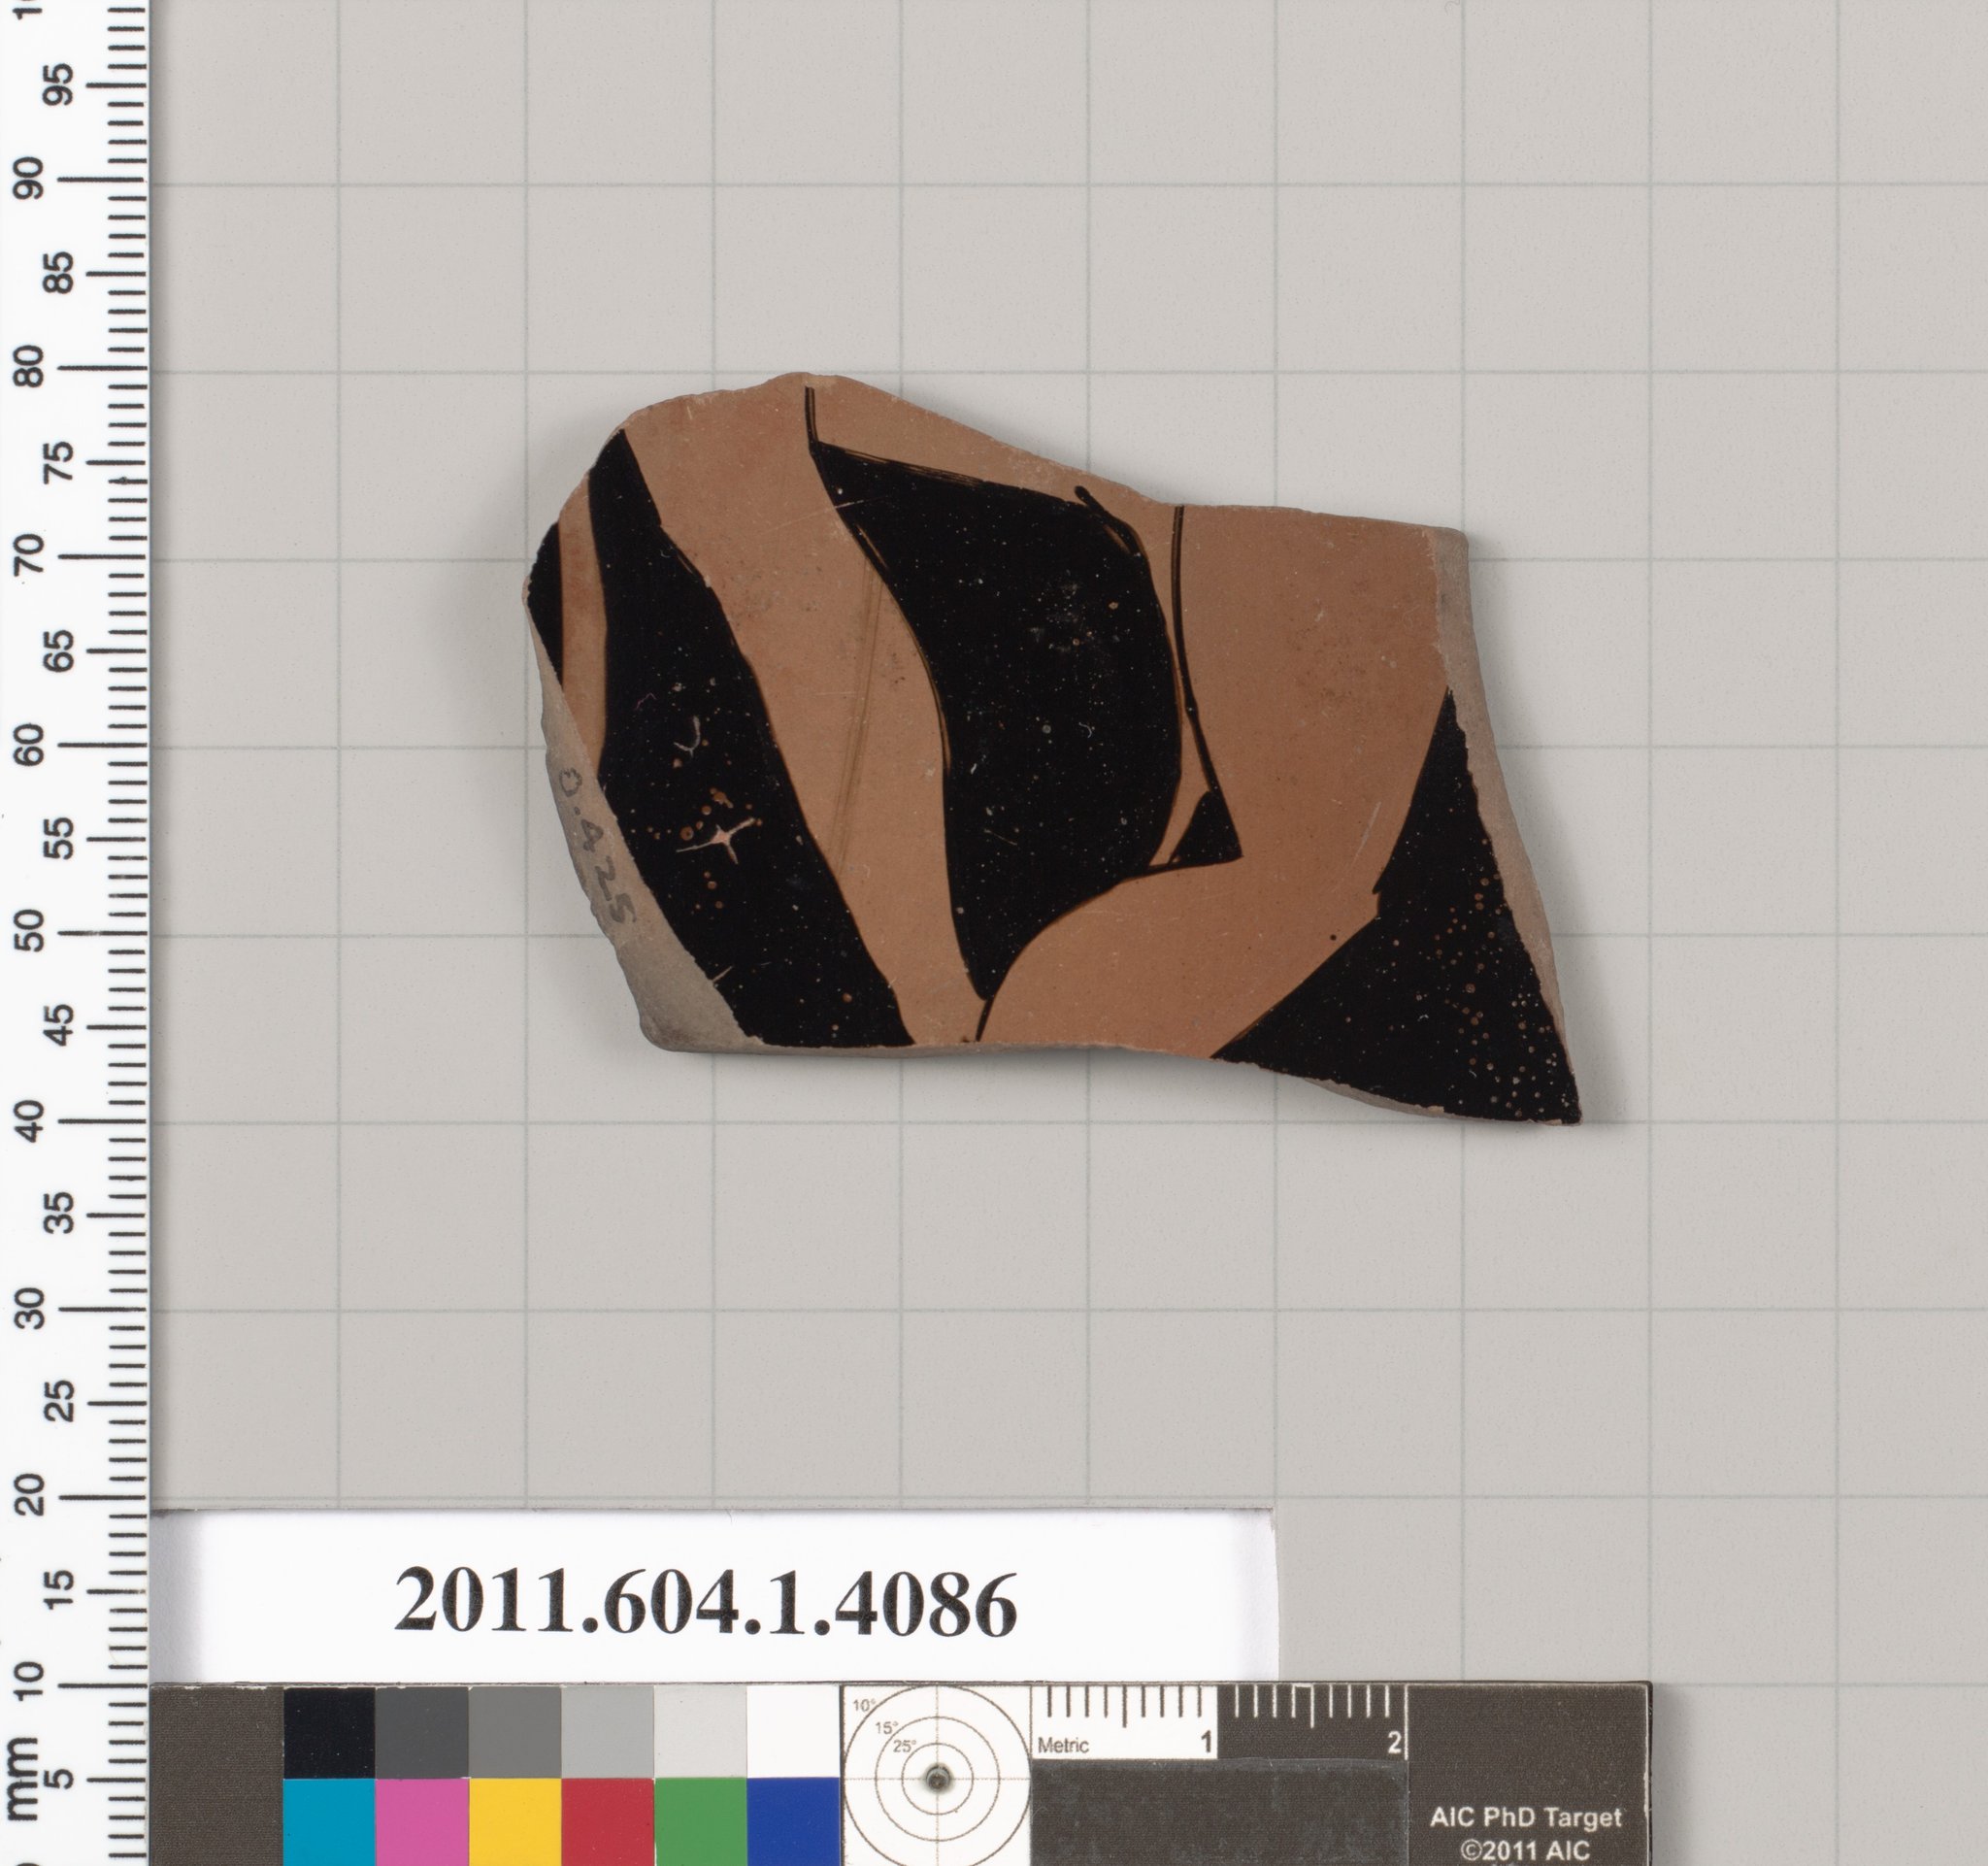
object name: kylix fragment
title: Terracotta fragment of a kylix (drinking cup)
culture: greek, attic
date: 520-500 BCE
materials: terracotta